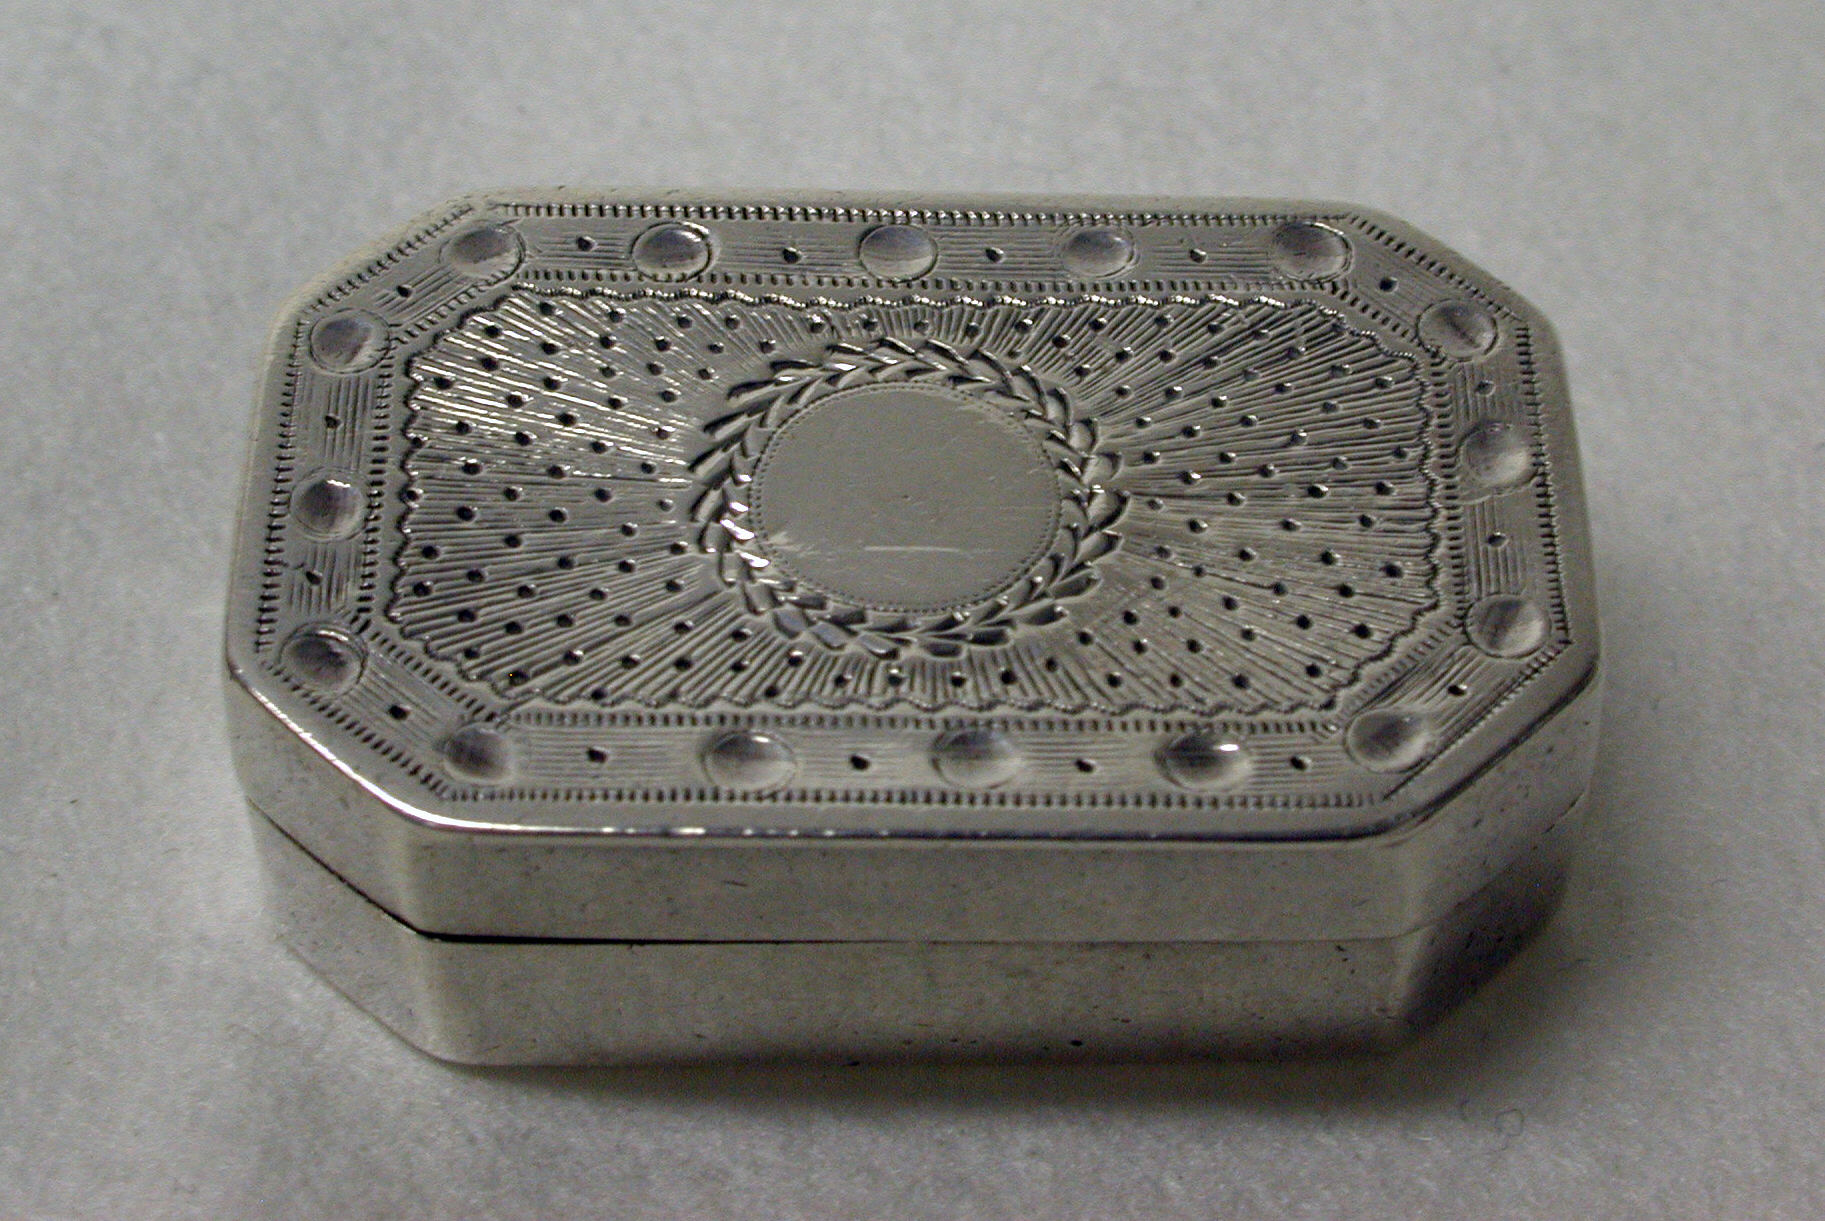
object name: vinaigrette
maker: thomas holland ii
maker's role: maker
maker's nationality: british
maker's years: 1798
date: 1799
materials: silver, silver gilt